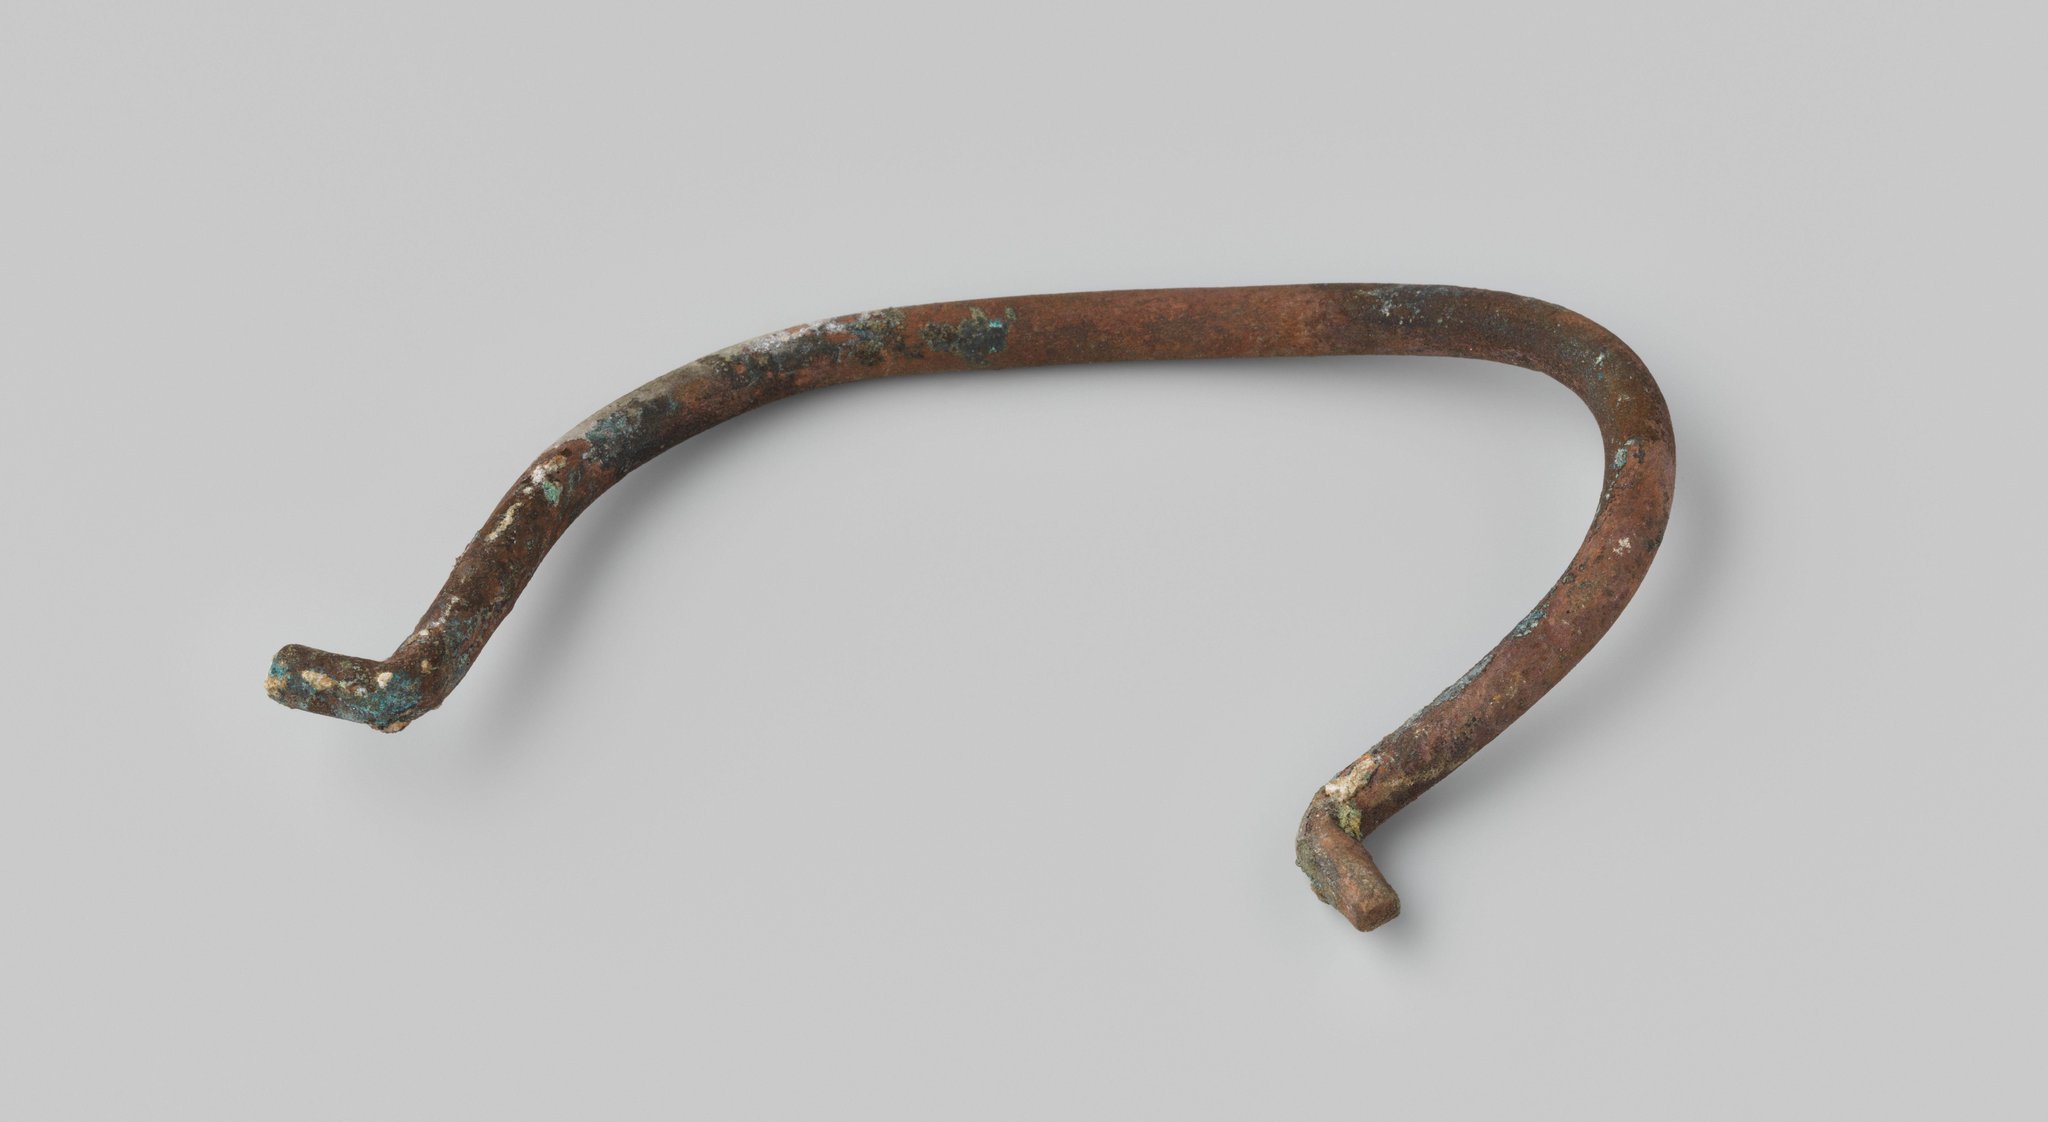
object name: bail handle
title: Beugelhandvat uit het wrak van de Oost-Indiëvaarder Hollandia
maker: Anonymous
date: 1700-1743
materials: copper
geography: netherlands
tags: verenigde oostindische compagnie, hollandia (schip), annet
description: Fittings, handles, bail handle; bent: originally semicircular, everted ends, circular in section.